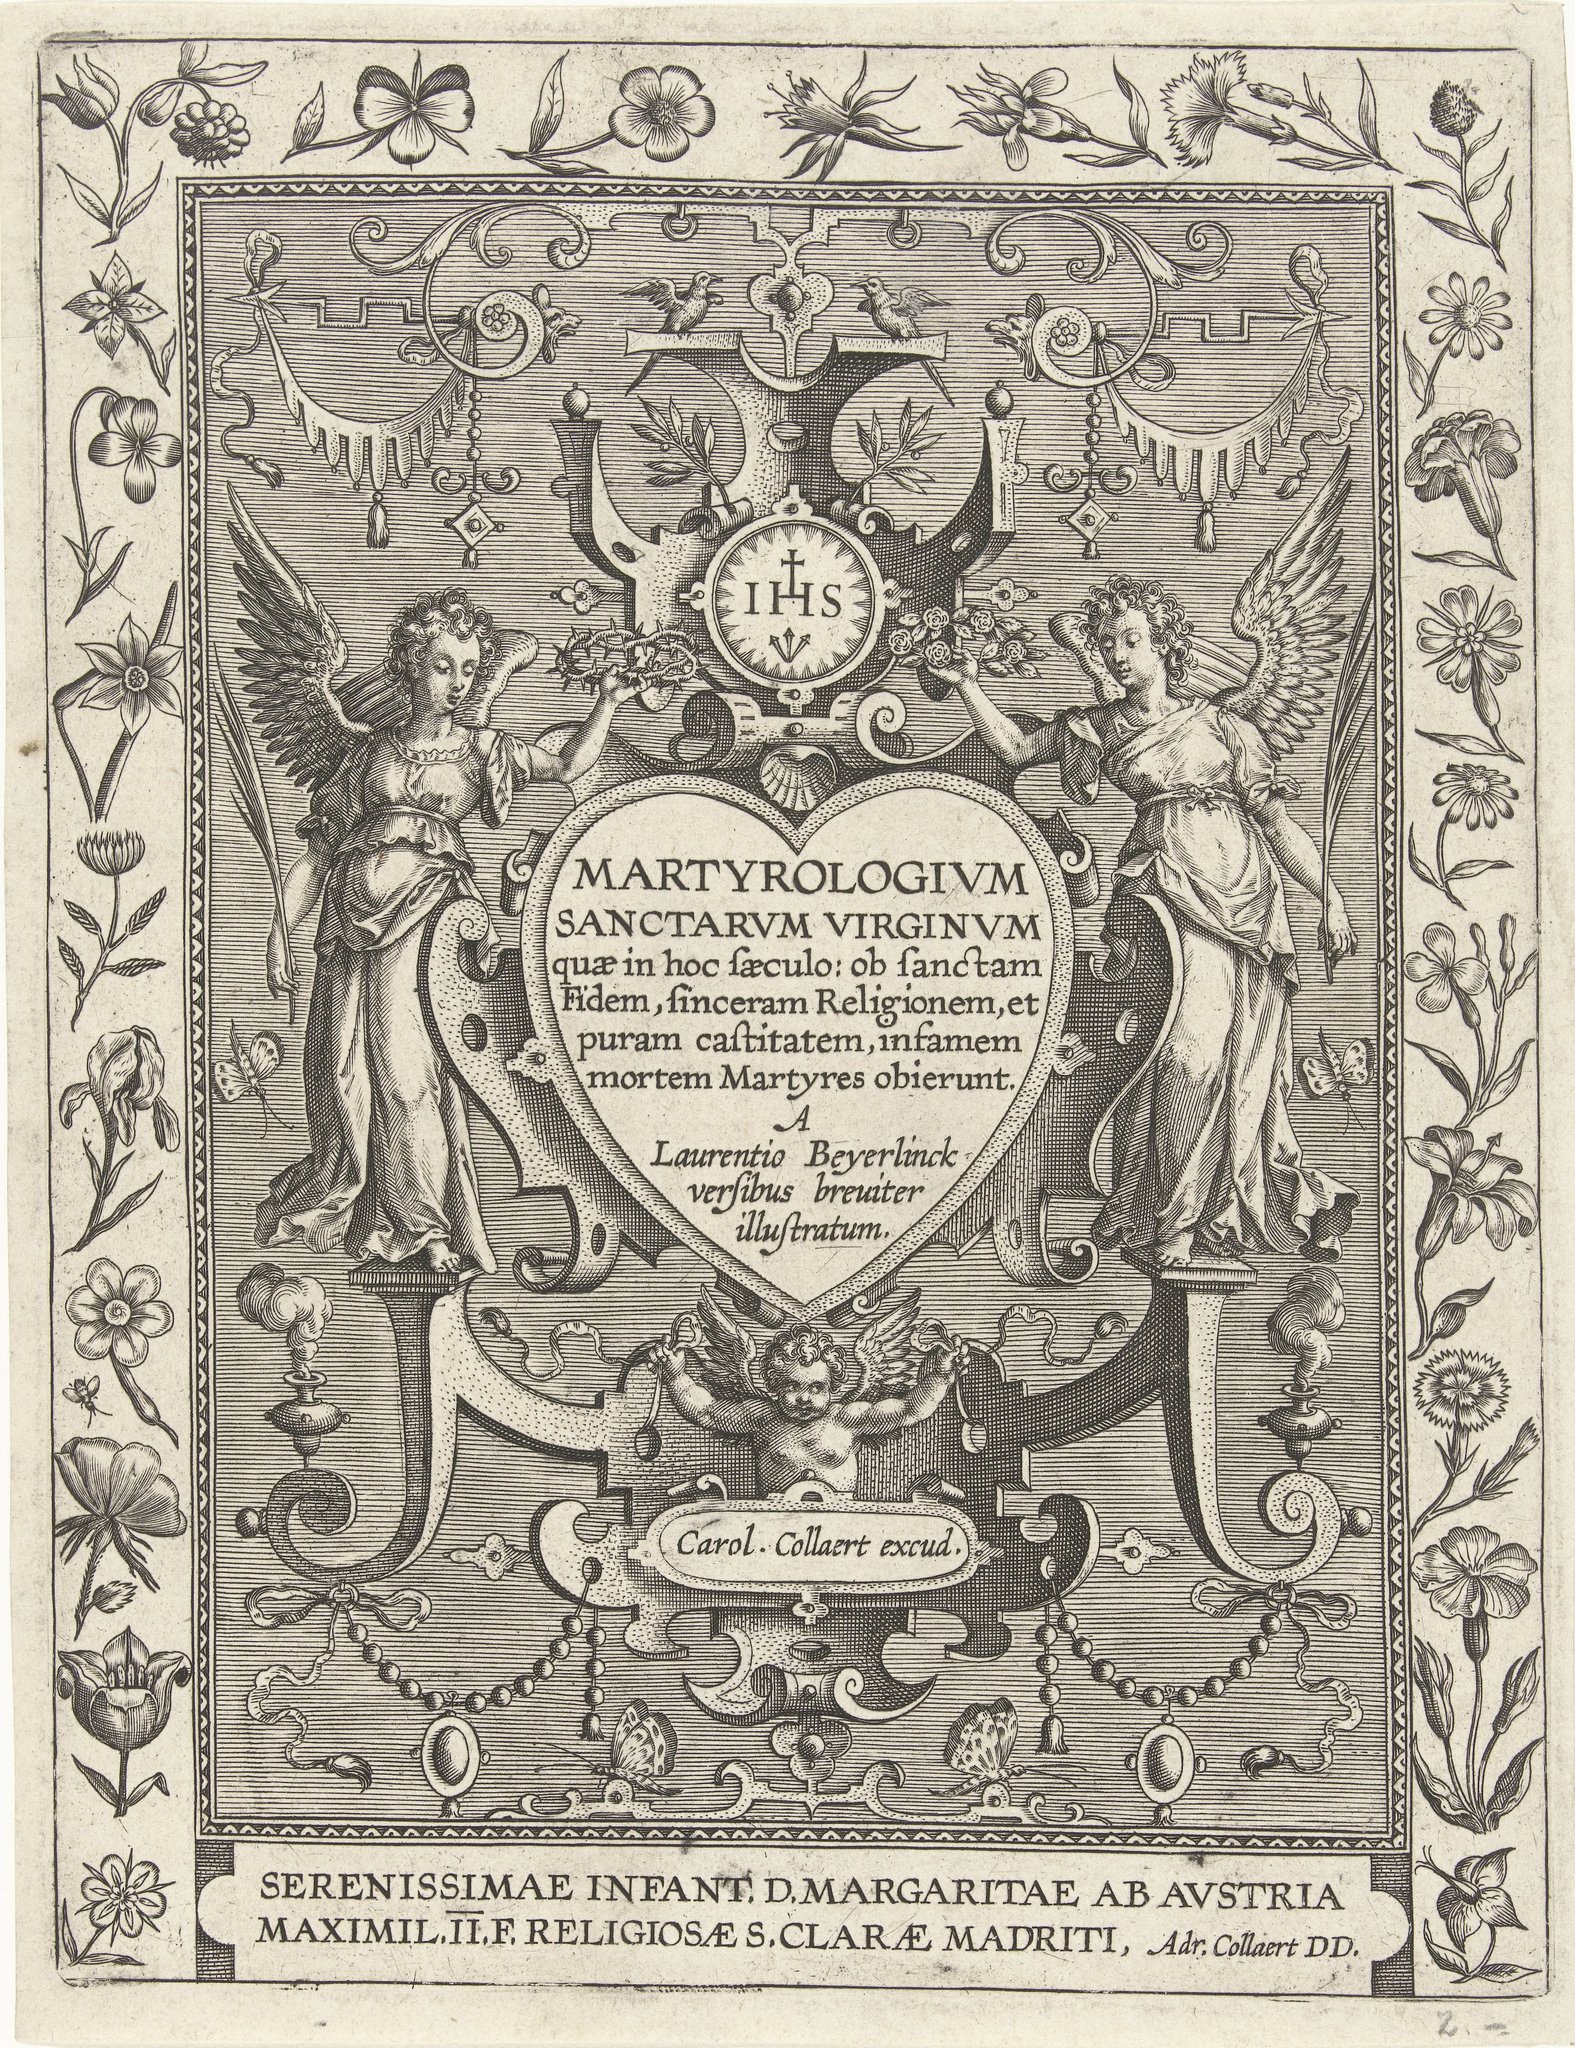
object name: titelprent, frontispice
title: Titelprent voor Martyrologium sanctarum virginum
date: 1570-1618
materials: paper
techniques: engraving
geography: antwerp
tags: fantasy ornament, ihs ('iesus hominum salvator') ~ symbol of christ, angels crowning and/or bringing palm-branches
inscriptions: collector's mark: Lugt 2228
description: Titelprent met versierde ornamenten. In het midden een hartvormige cartouche met de Latijnse titel. Twee engelen naast de cartouche. Boven de cartouche het monogram IHS.